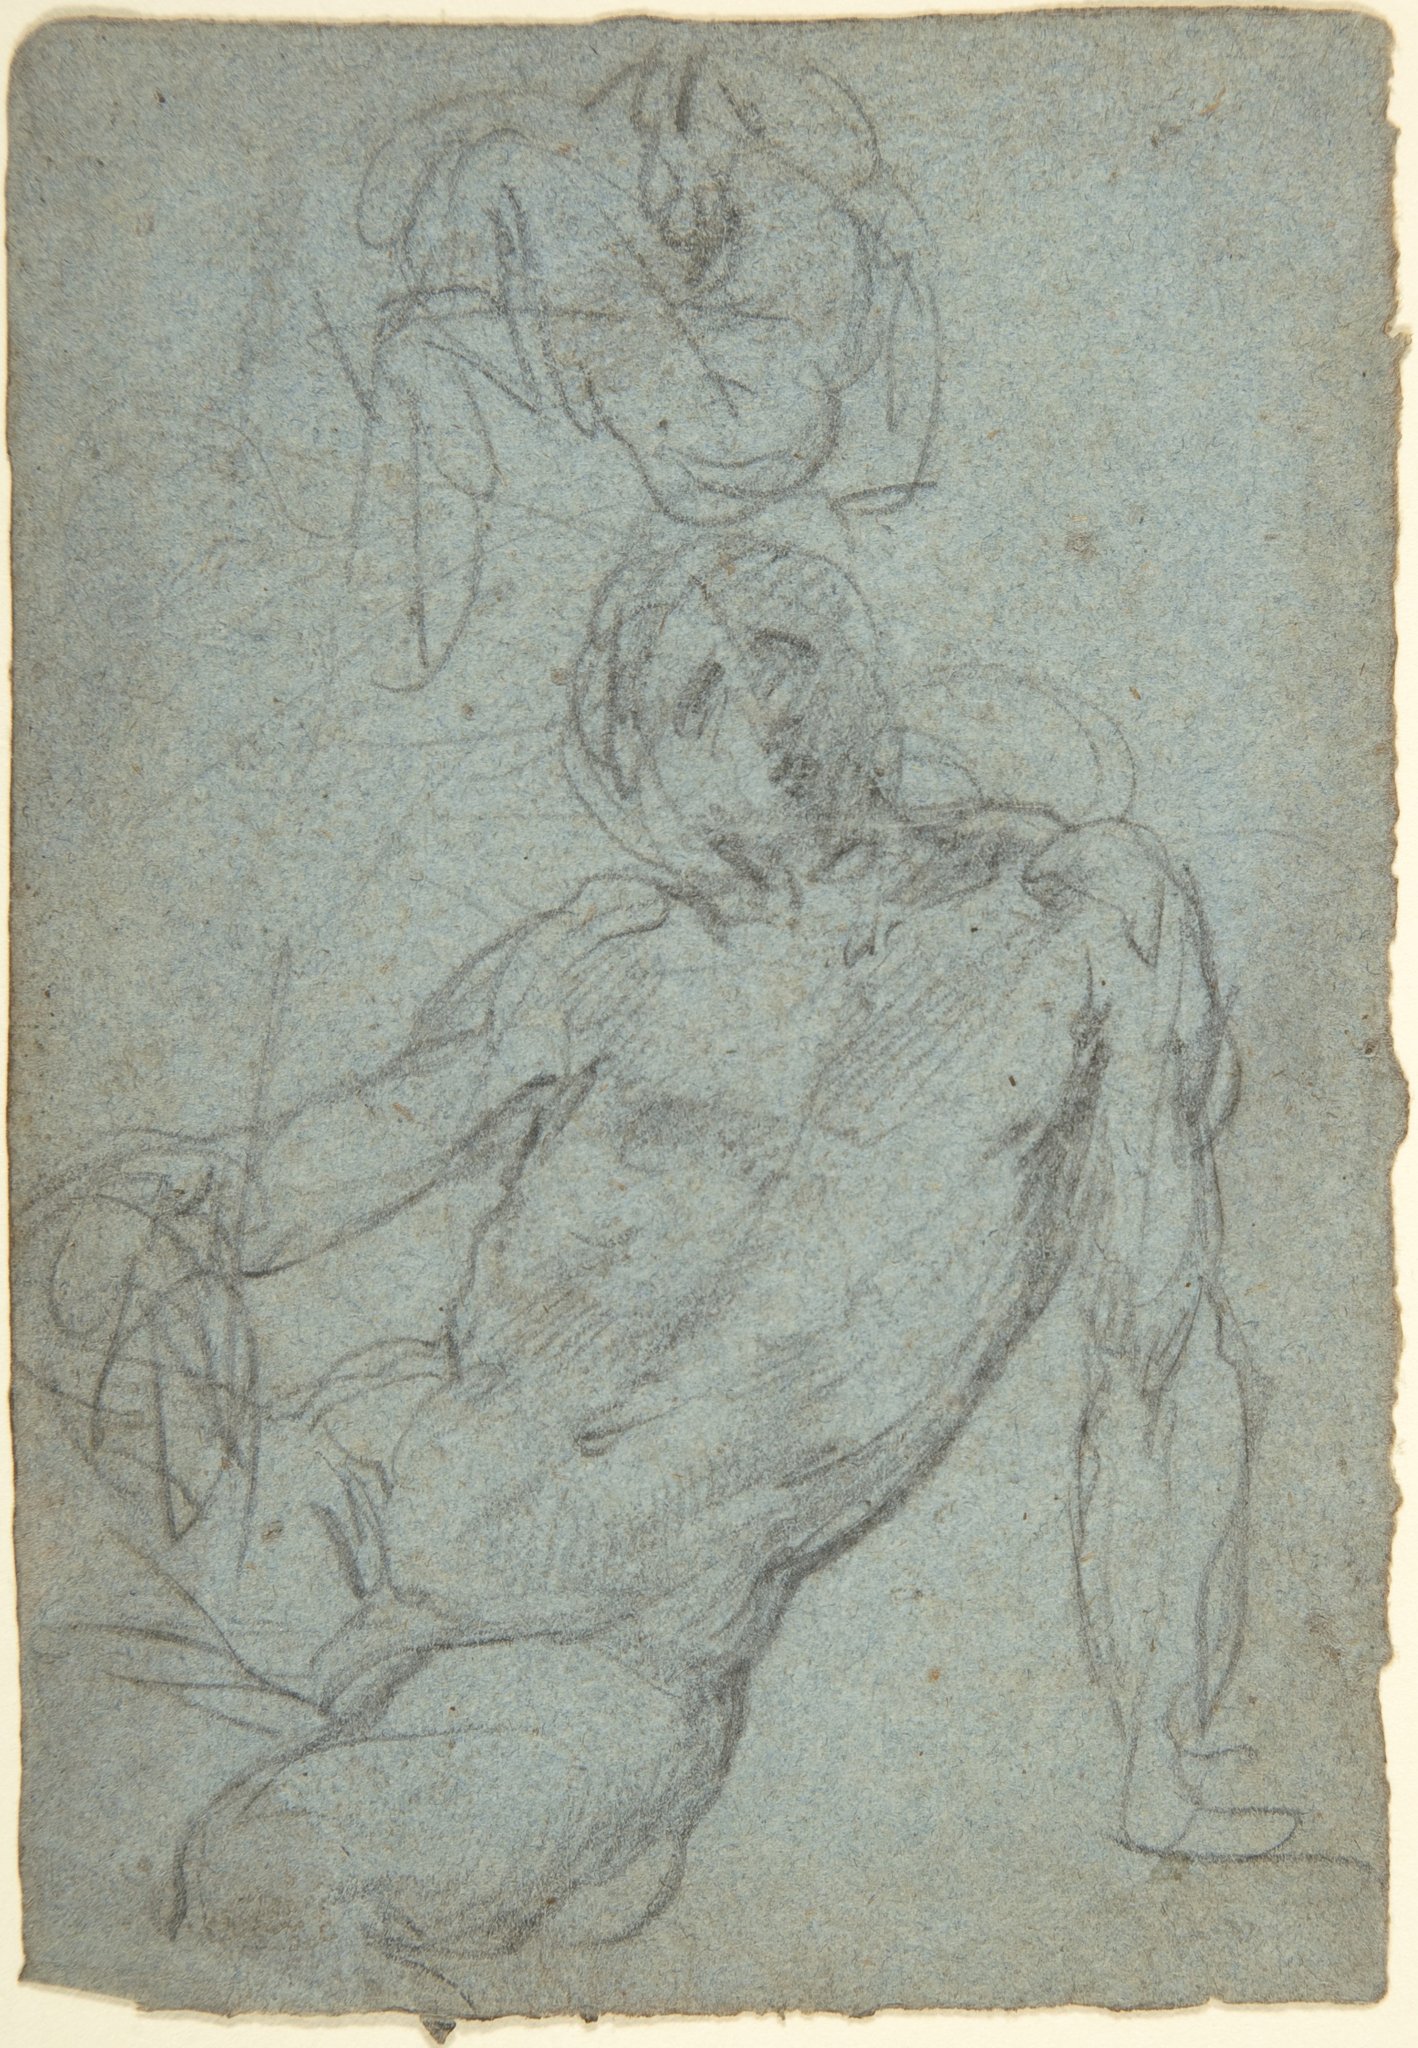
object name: drawing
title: Studies of a Seated Nude Male Figure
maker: giulio cesare procaccini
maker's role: artist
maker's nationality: italian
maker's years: 1574-1625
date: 1602-1605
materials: chalk, paper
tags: male nudes